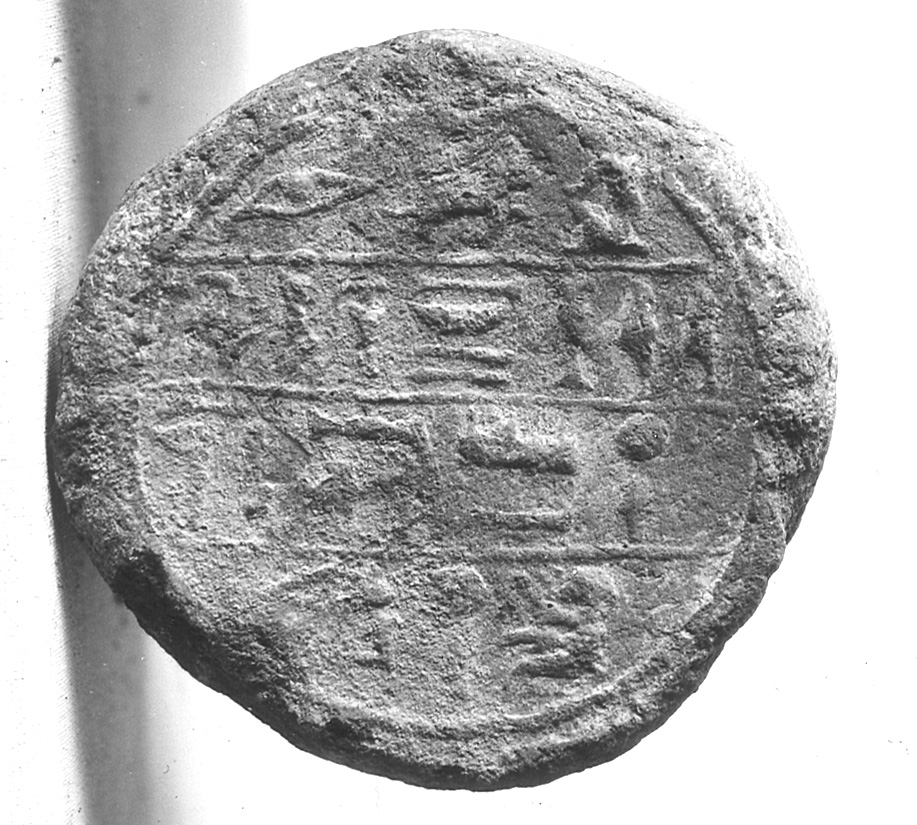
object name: cone, circular impression, re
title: Funerary Cone of Re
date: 1550-1352 BCE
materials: pottery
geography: egypt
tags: hieroglyphs